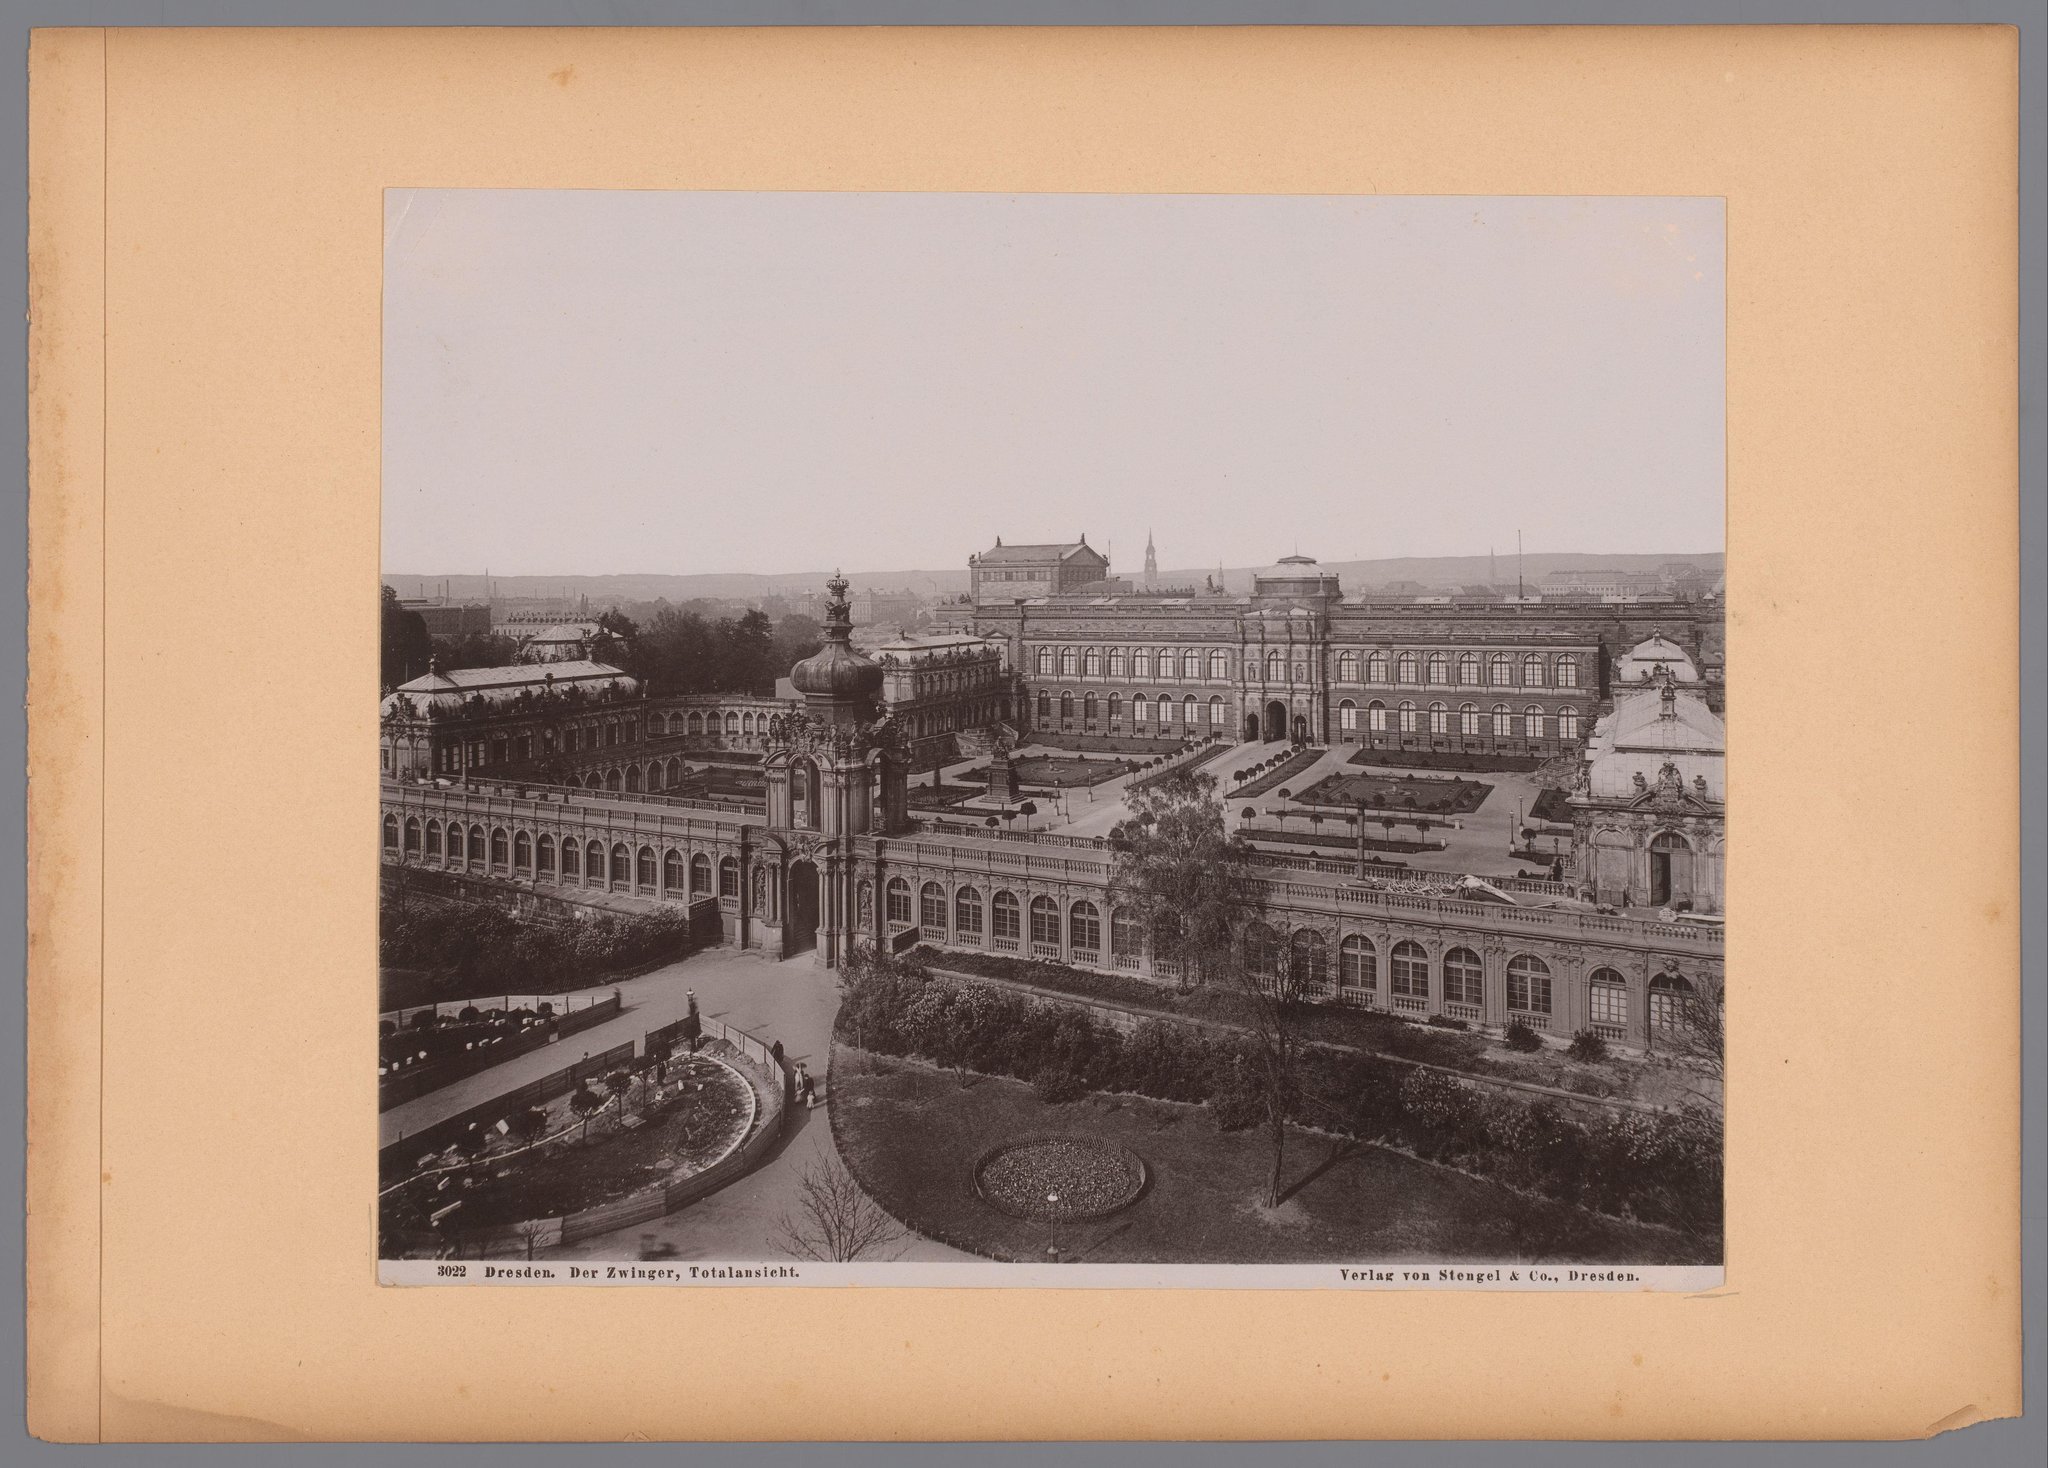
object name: photograph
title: albumblad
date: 1900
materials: paper, photographic support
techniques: photoaquatint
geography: germany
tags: dresden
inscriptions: inscription: ‘Verlag von Stengel & Co., Dresden.’, check stamp: ‘STENGEL & CO.//1900//DRESDEN’, inscription: ‘3022 Dresden, Der Zwinger, Totalansicht’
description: De "Zwinger" is een paleiscomplex in de laat-barokke bouwstijl in de Duitse stad Dresden dat werd gebouwd tussen 1710 en 1728. Het doet nu dienst als museum.